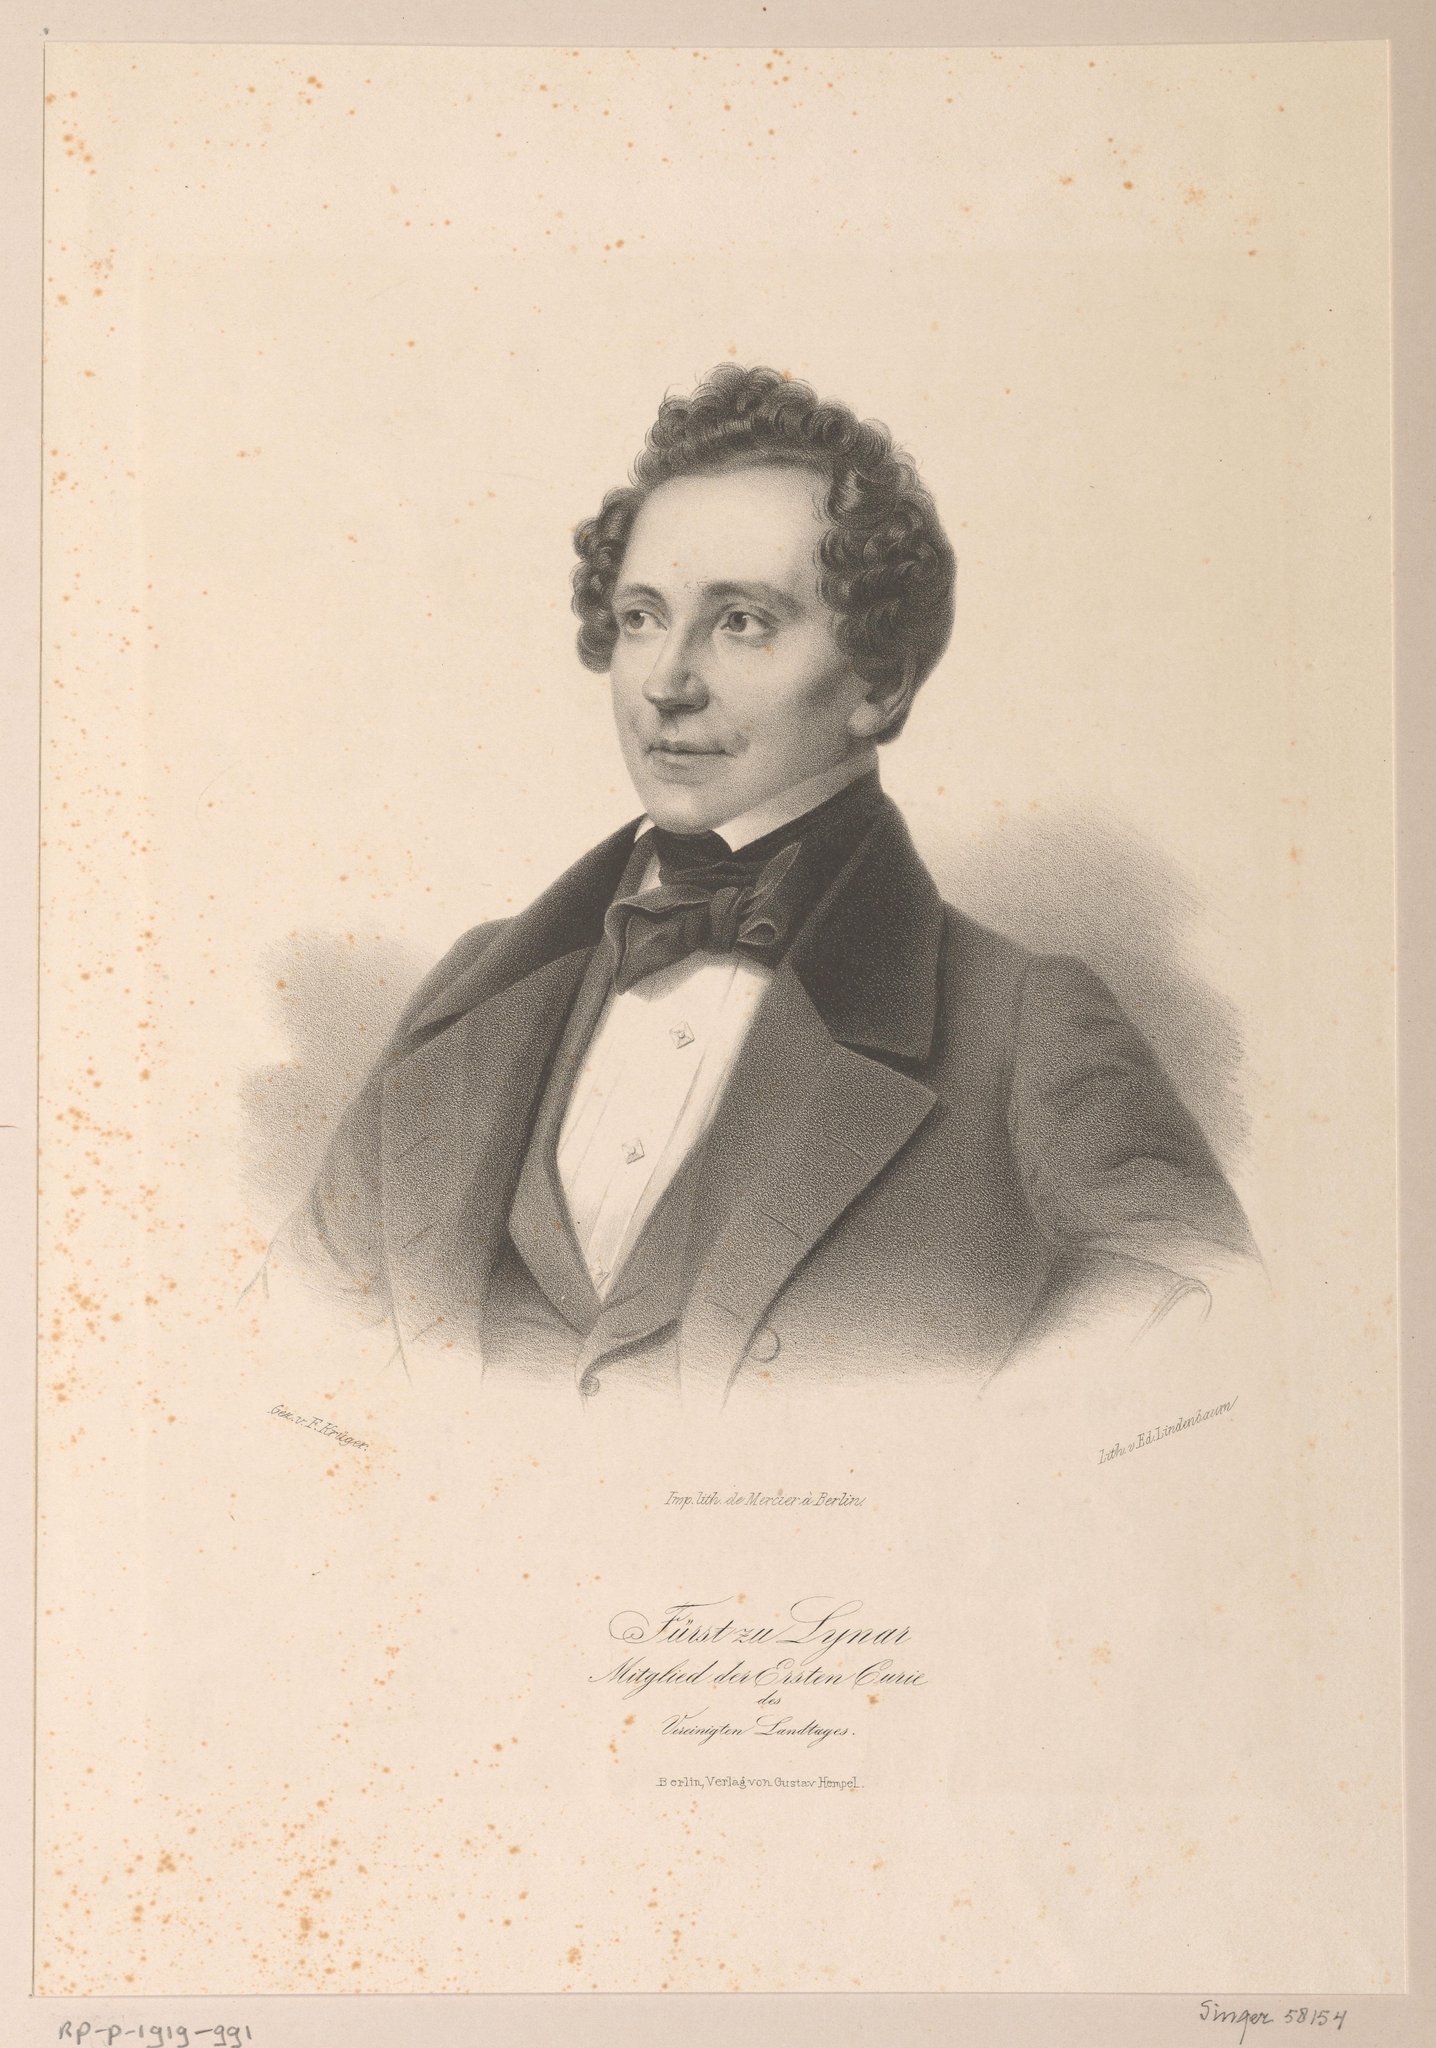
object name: print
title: Portret van Rochus Otto Manderup Heinrich zu Lynar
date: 1846-1857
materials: paper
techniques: lithograph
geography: berlin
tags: politician, historical persons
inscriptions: collector's mark: Lugt 2228